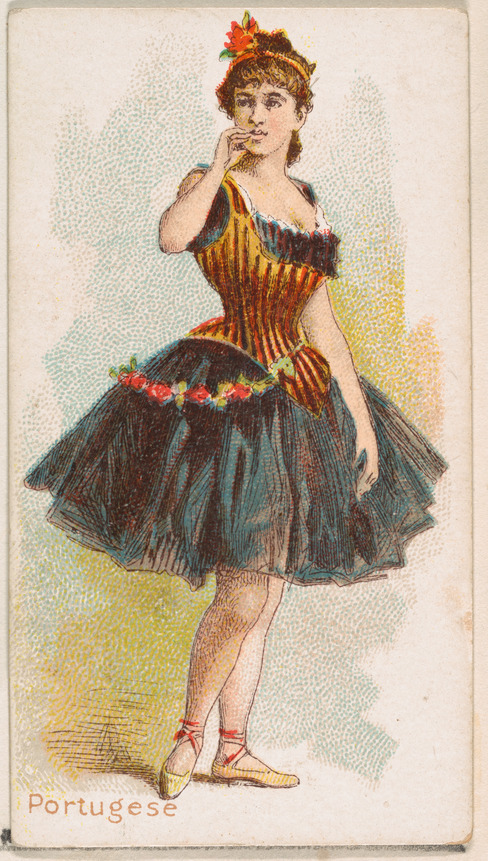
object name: print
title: Portuguese Dancer, from the Dancing Women series (N186) issued by Wm. S. Kimball & Co.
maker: william s. kimball & company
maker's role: publisher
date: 1889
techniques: color lithograph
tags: women,dancers